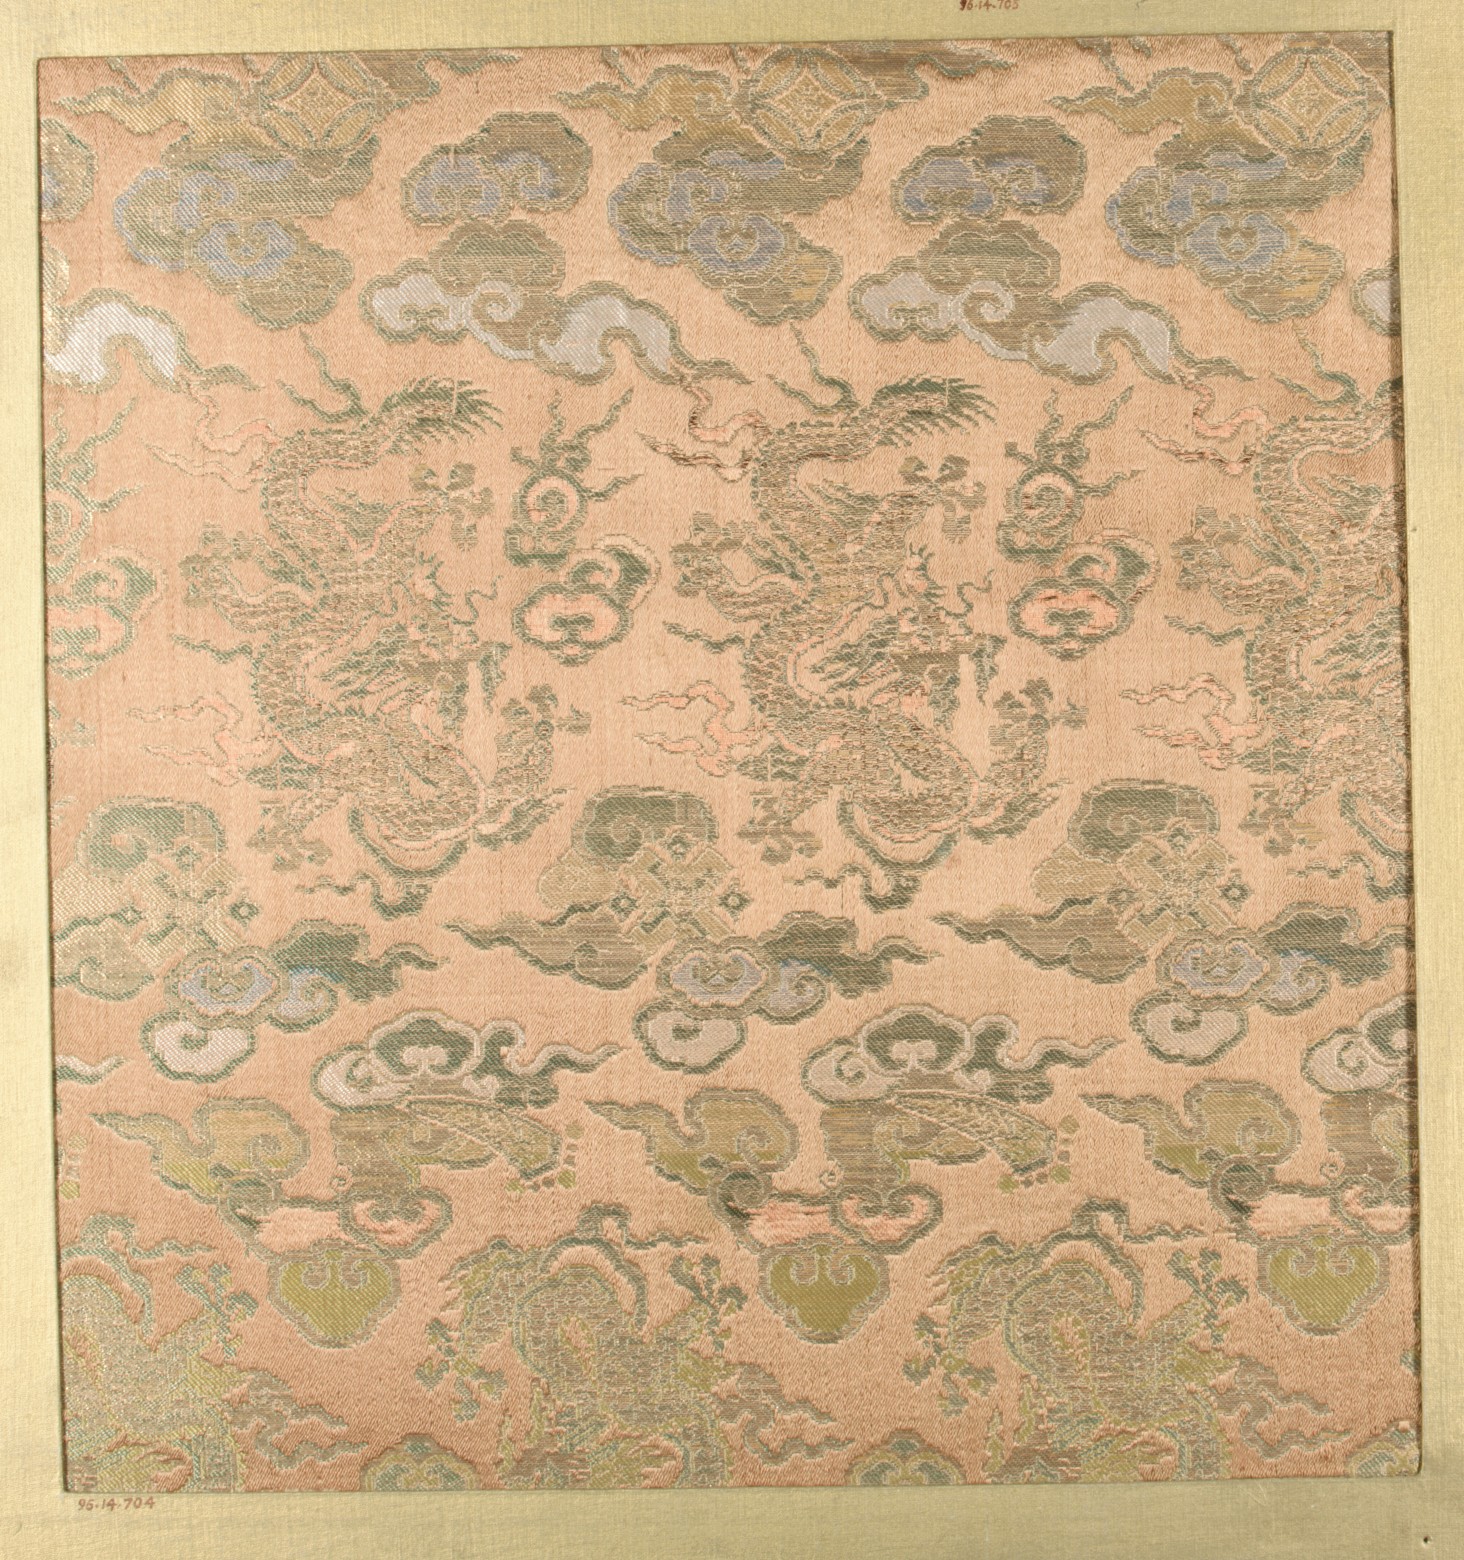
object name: piece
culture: chinese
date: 1701-1900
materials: silk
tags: dragons